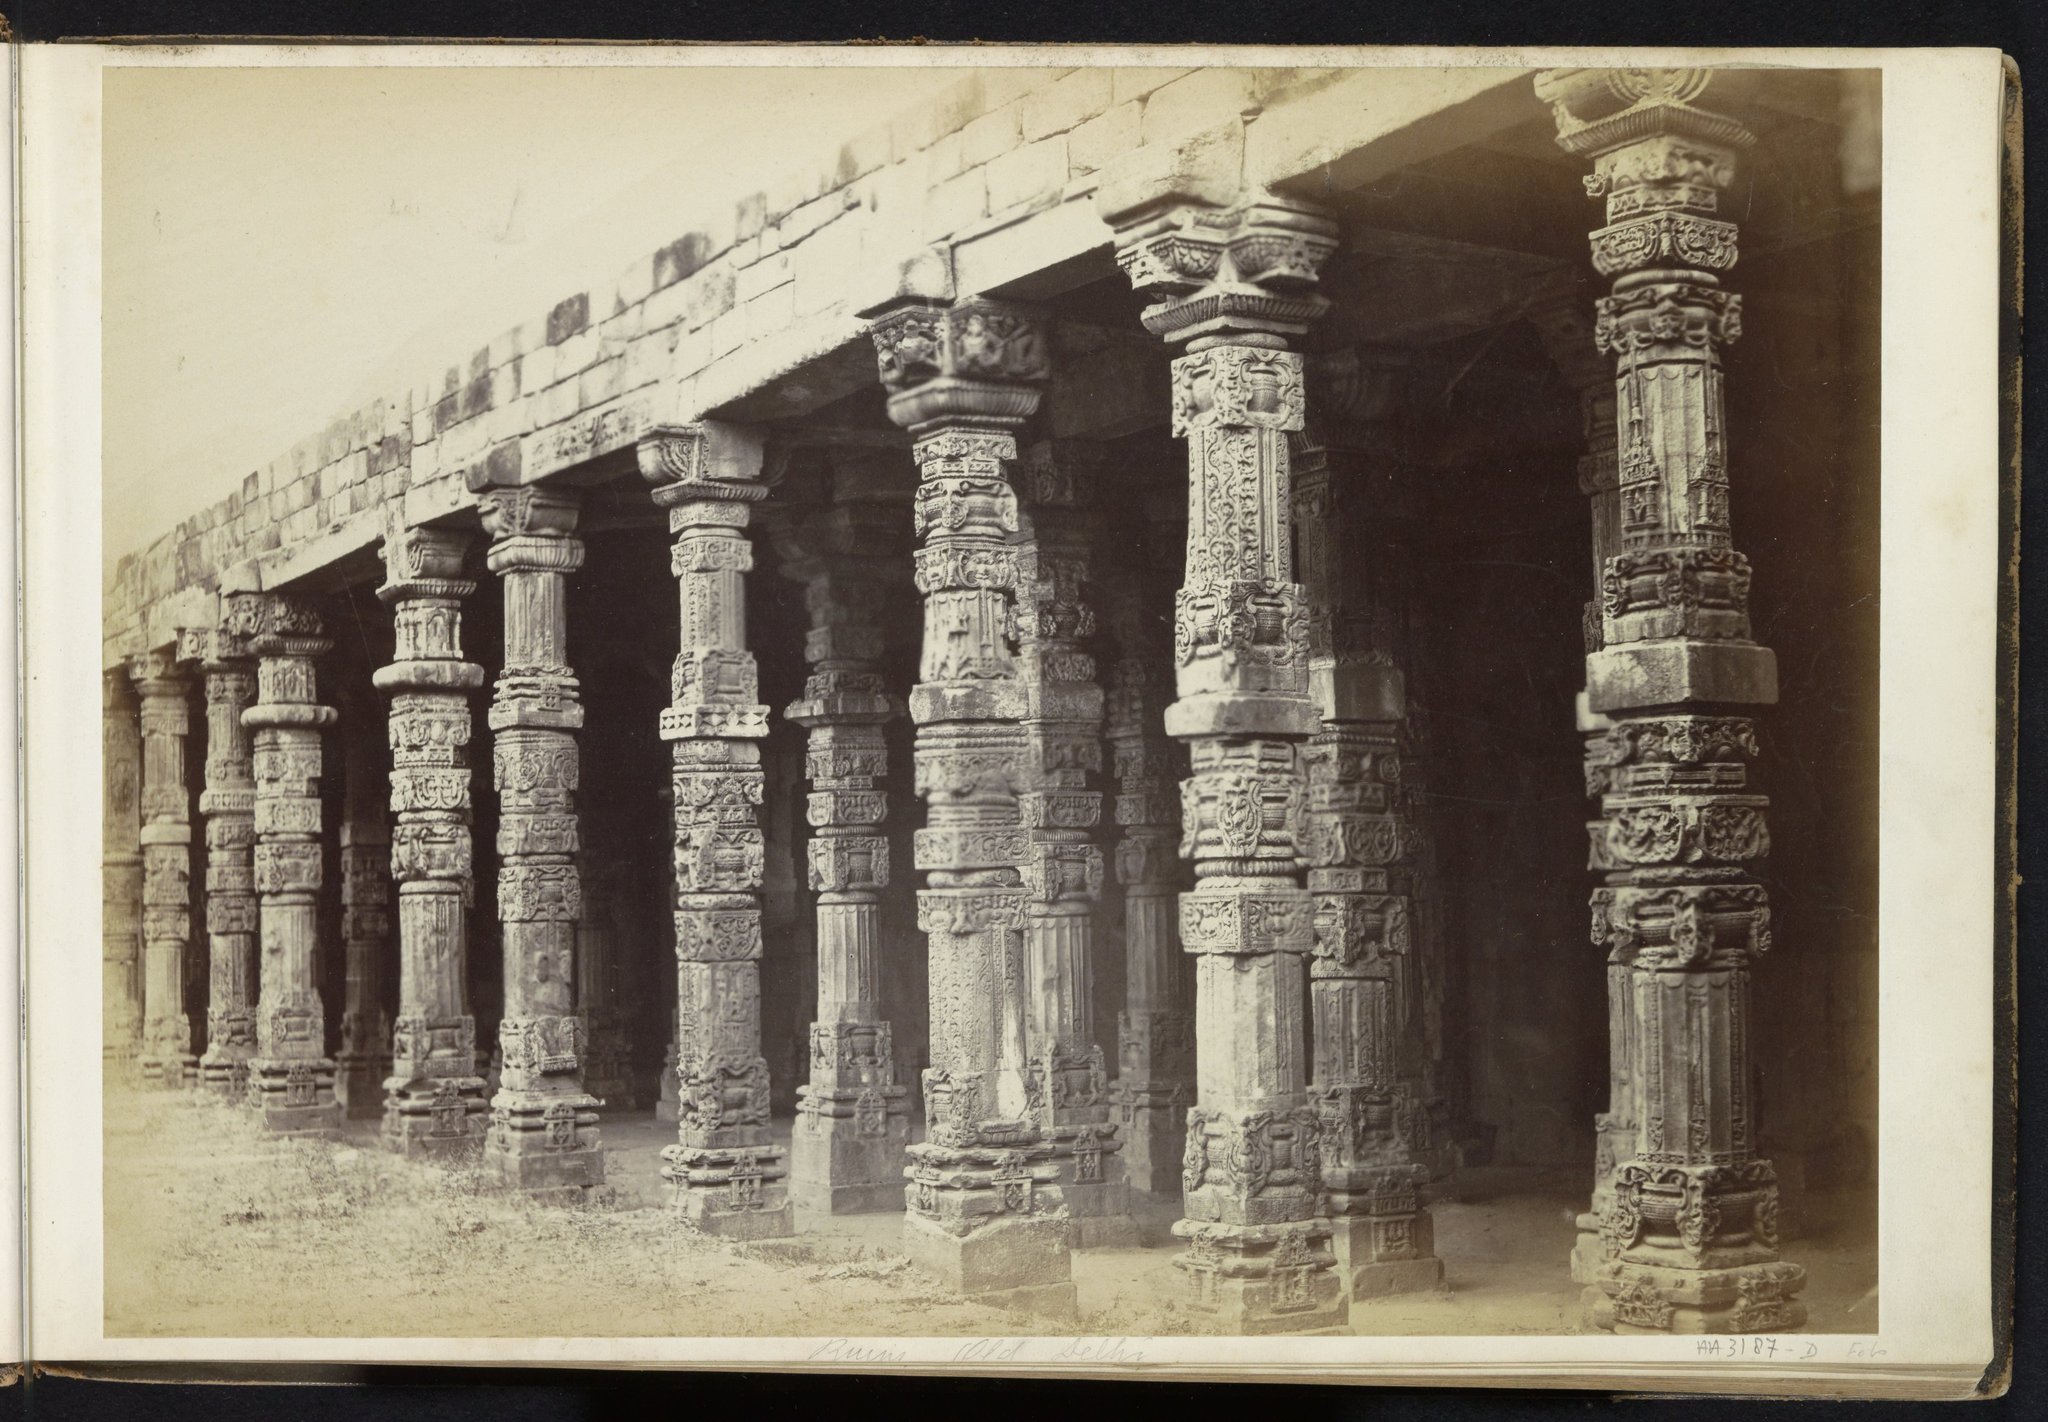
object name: album leaf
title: Colonnade at the Qutb complex in Delhi, India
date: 1862-1863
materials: paper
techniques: albumen print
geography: delhi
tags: colonnade, ruin of a building ~ architecture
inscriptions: title: ‘Ruins Old Delhi’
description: Onderdeel van Reisalbum met opnames van bezienswaardigheden in India, Duitsland, Zwitserland en Frankrijk.